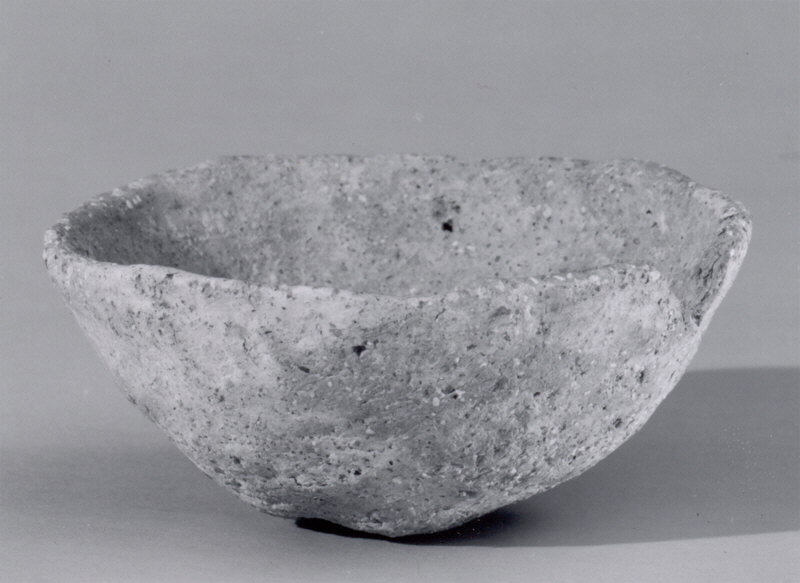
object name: bowl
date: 3500-3300 BCE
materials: ceramic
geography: levant